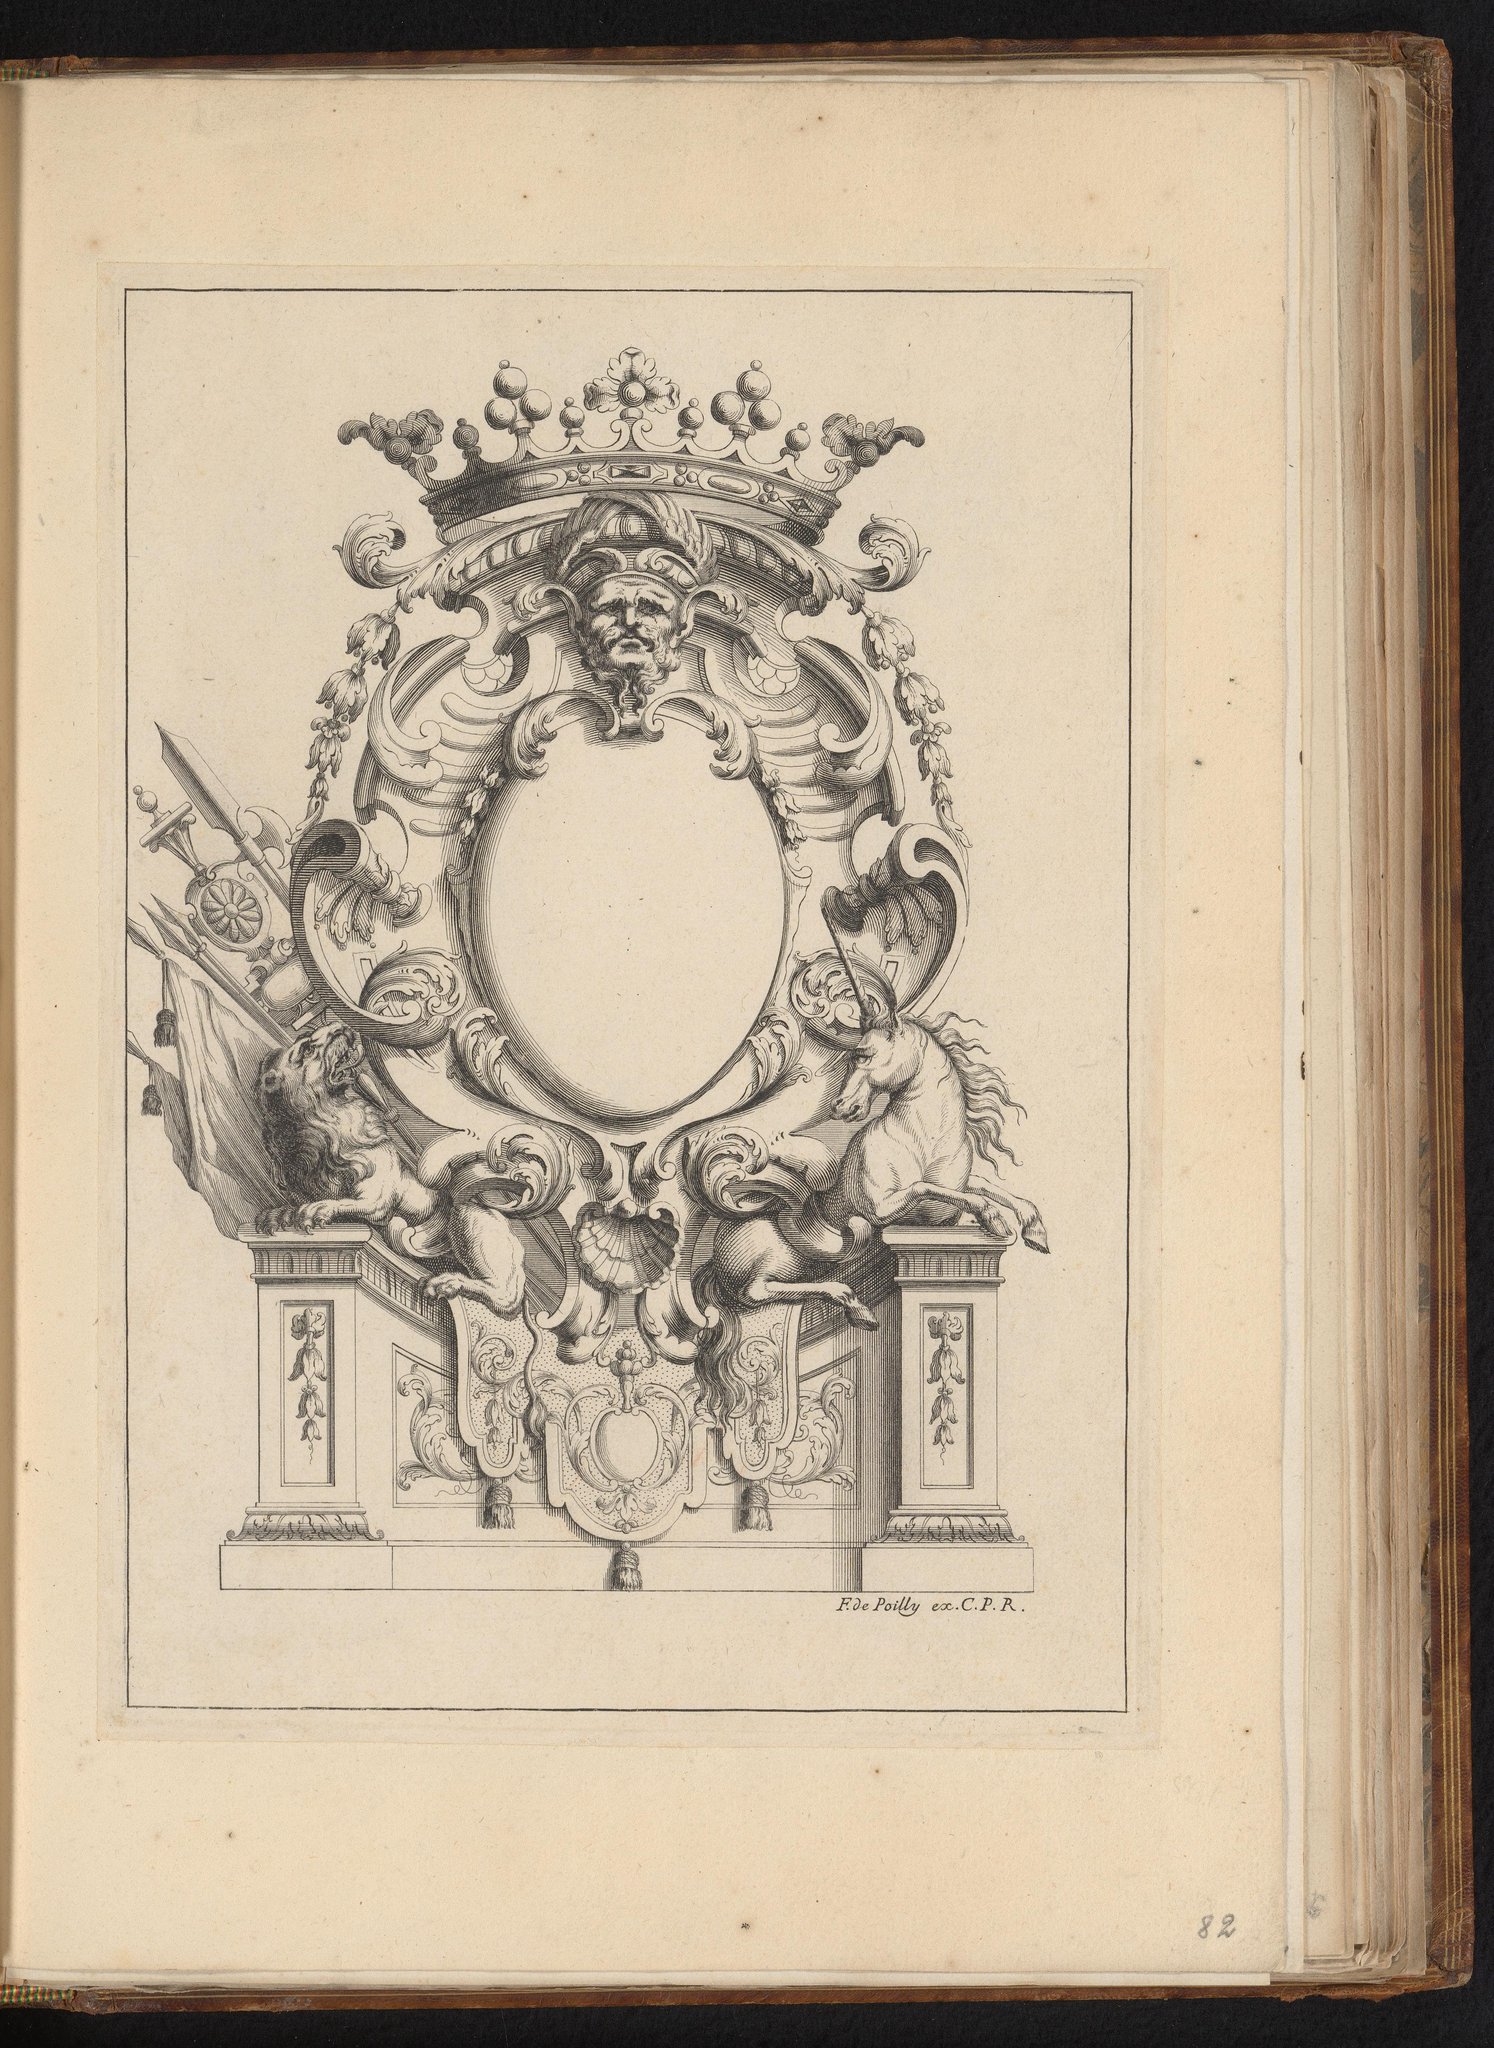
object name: print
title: Ontwerpen voor cartouches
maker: Anonymous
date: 1682-1723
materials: paper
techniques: etching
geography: france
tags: unicorn, ornament ~ cartouche, beasts of prey, predatory animals: lion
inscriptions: collector's mark: Lugt 2760, collector's mark: Lugt 2228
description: Prent maakt deel uit van een serie van zes prenten.